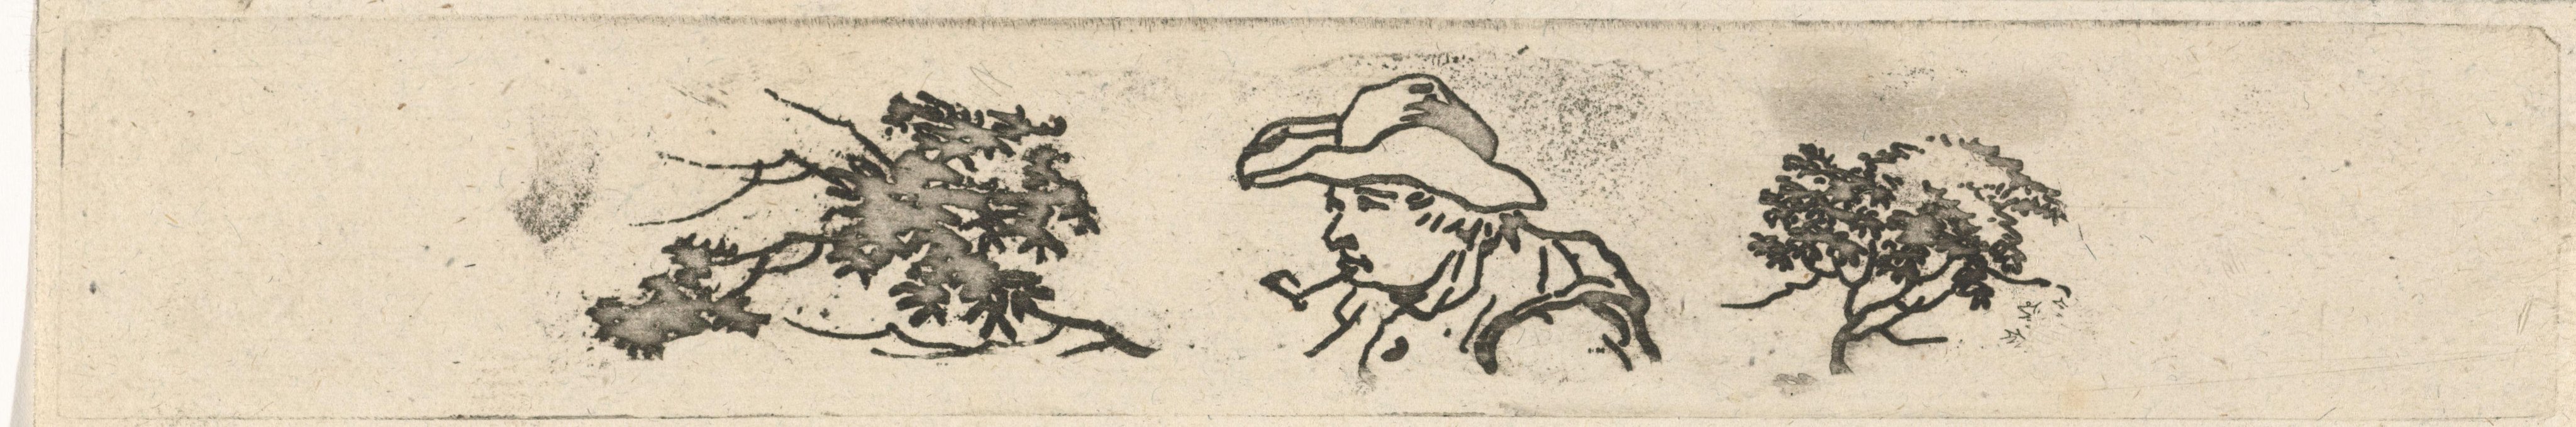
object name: print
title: Studieblad met twee bomen en een rokende boer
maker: françois joseph pfeiffer (ii)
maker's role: draughtsman, print maker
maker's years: 1778-1835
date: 1793-1835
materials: paper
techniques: aquatint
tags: trees, chest, bust, pipe ~ tobacco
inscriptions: collector's mark: Lugt 2228